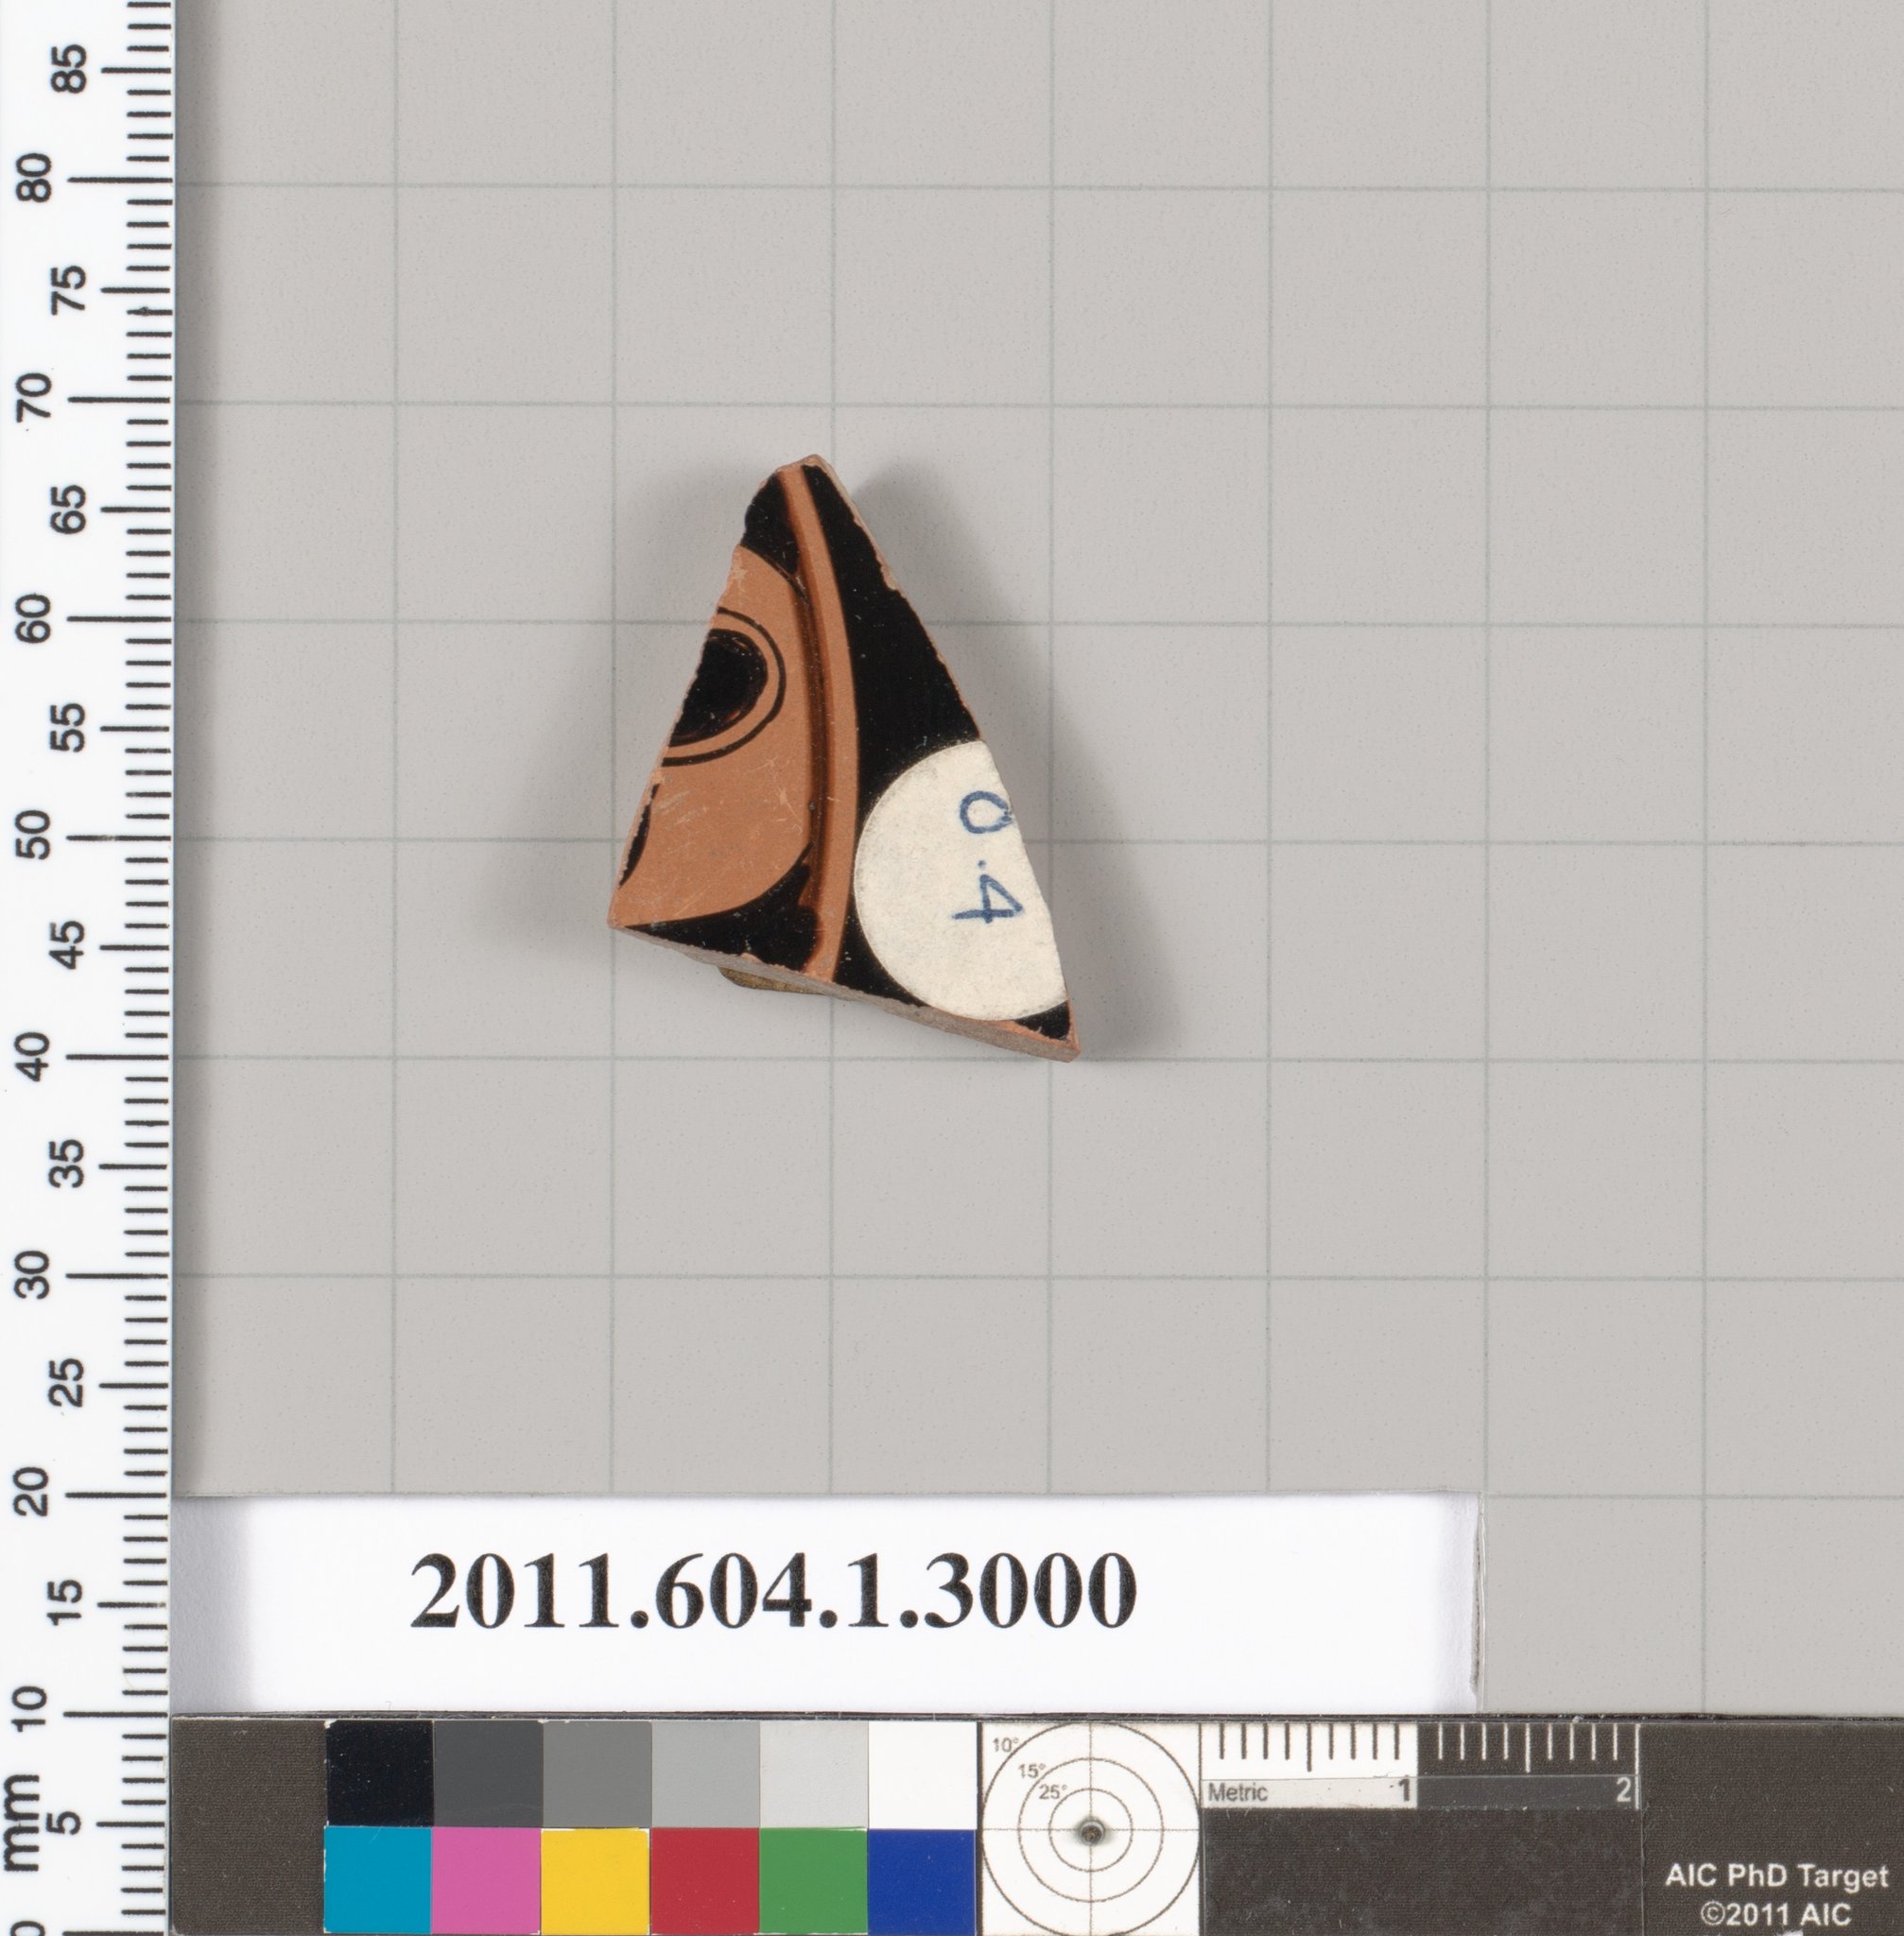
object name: kylix fragment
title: Terracotta fragment of a kylix (drinking cup)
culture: greek, attic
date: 500-480 BCE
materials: terracotta